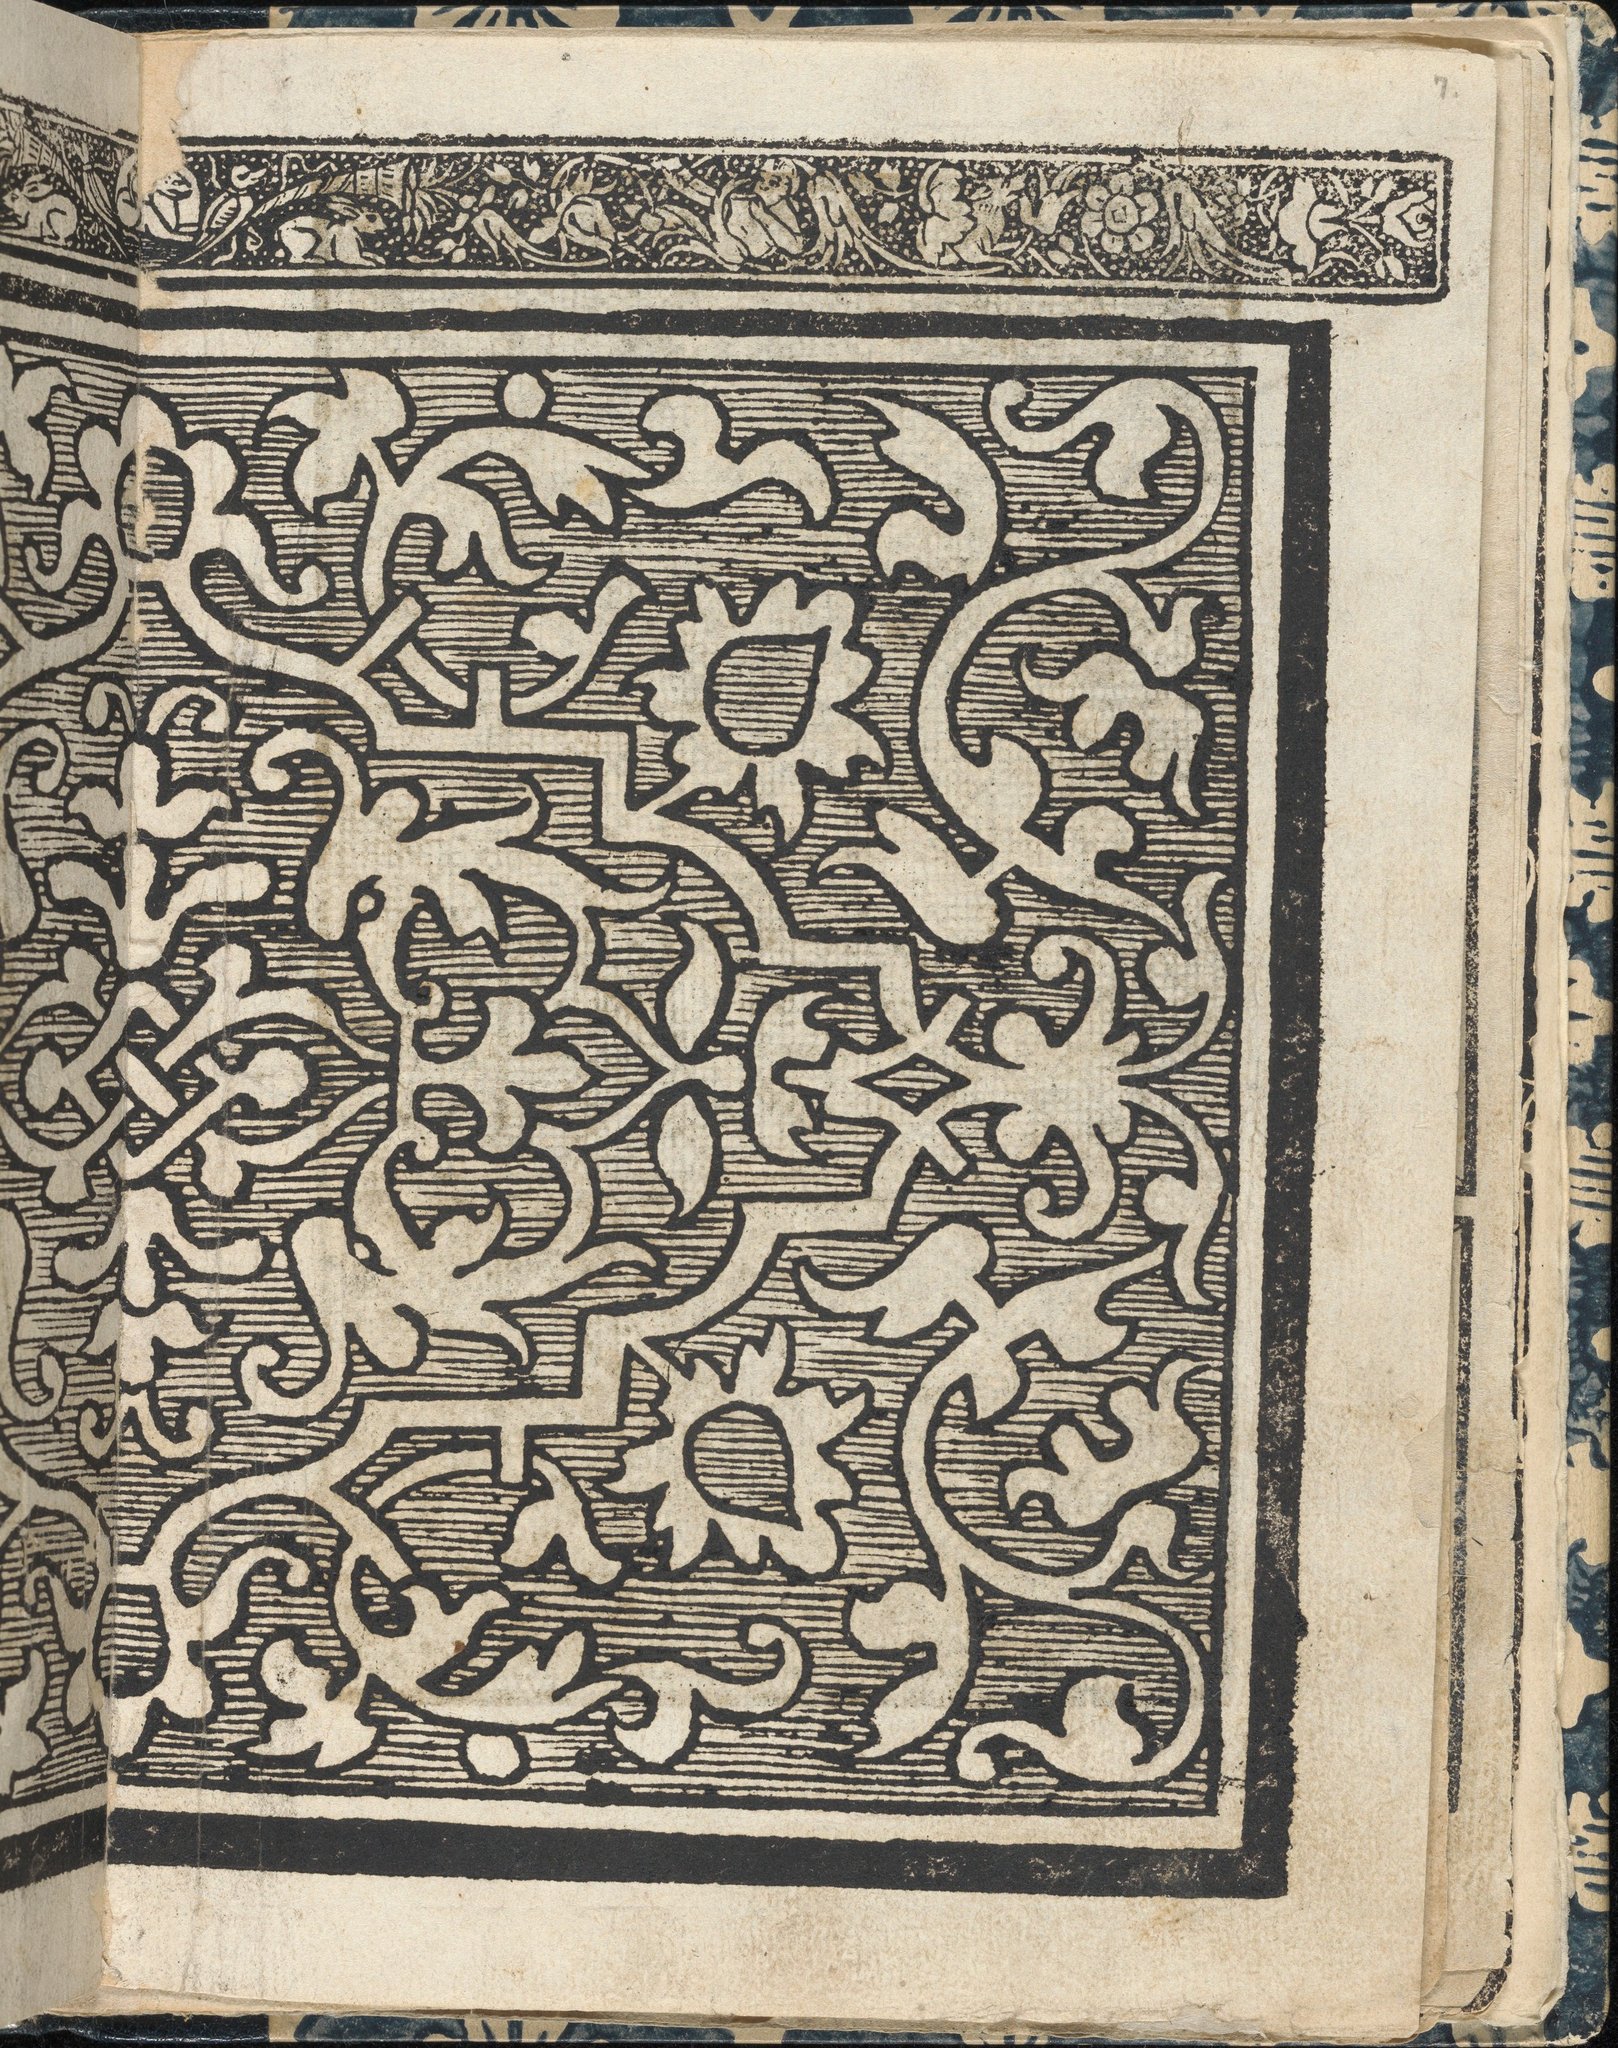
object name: book print ornament architecture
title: Essempio di recammi, page 7 (recto)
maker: giovanni antonio tagliente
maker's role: author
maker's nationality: italian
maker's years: 1465-1528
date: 1530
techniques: woodcut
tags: flowers